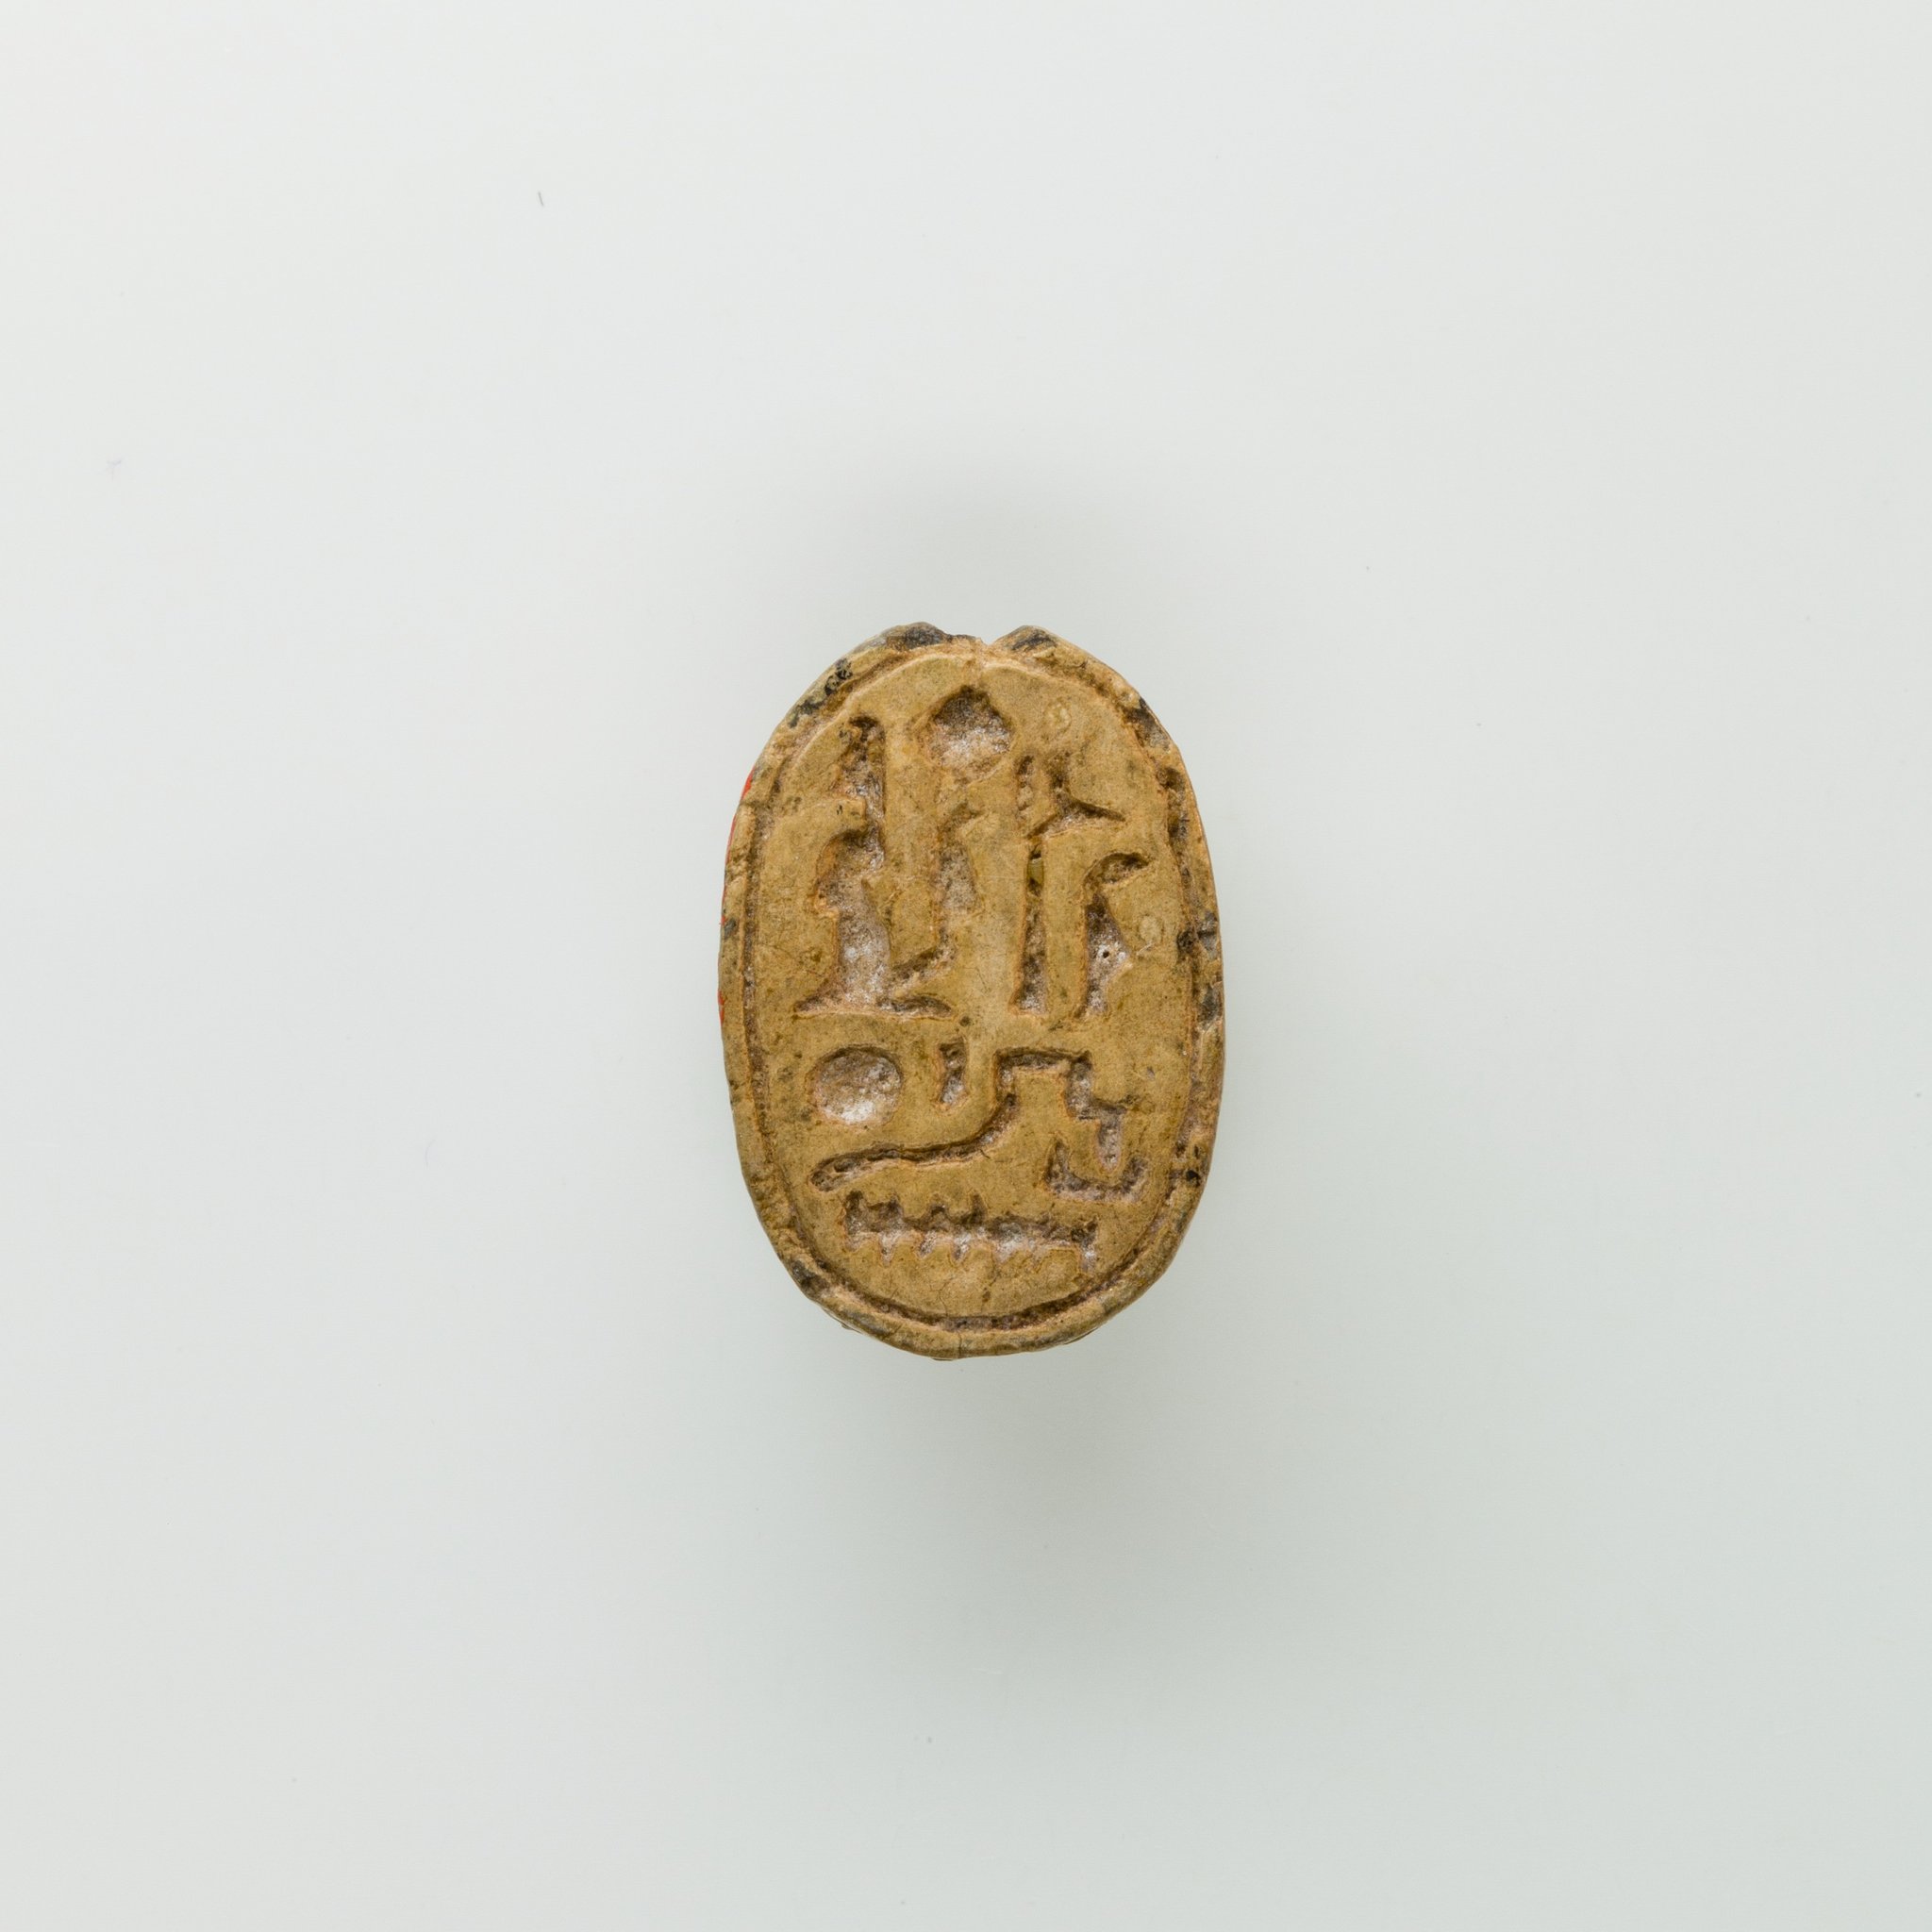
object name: scarab, ramesses ii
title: Scarab of Ramesses II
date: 1295-1070 BCE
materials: stone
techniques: glazing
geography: egypt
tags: hieroglyphs,scarabs